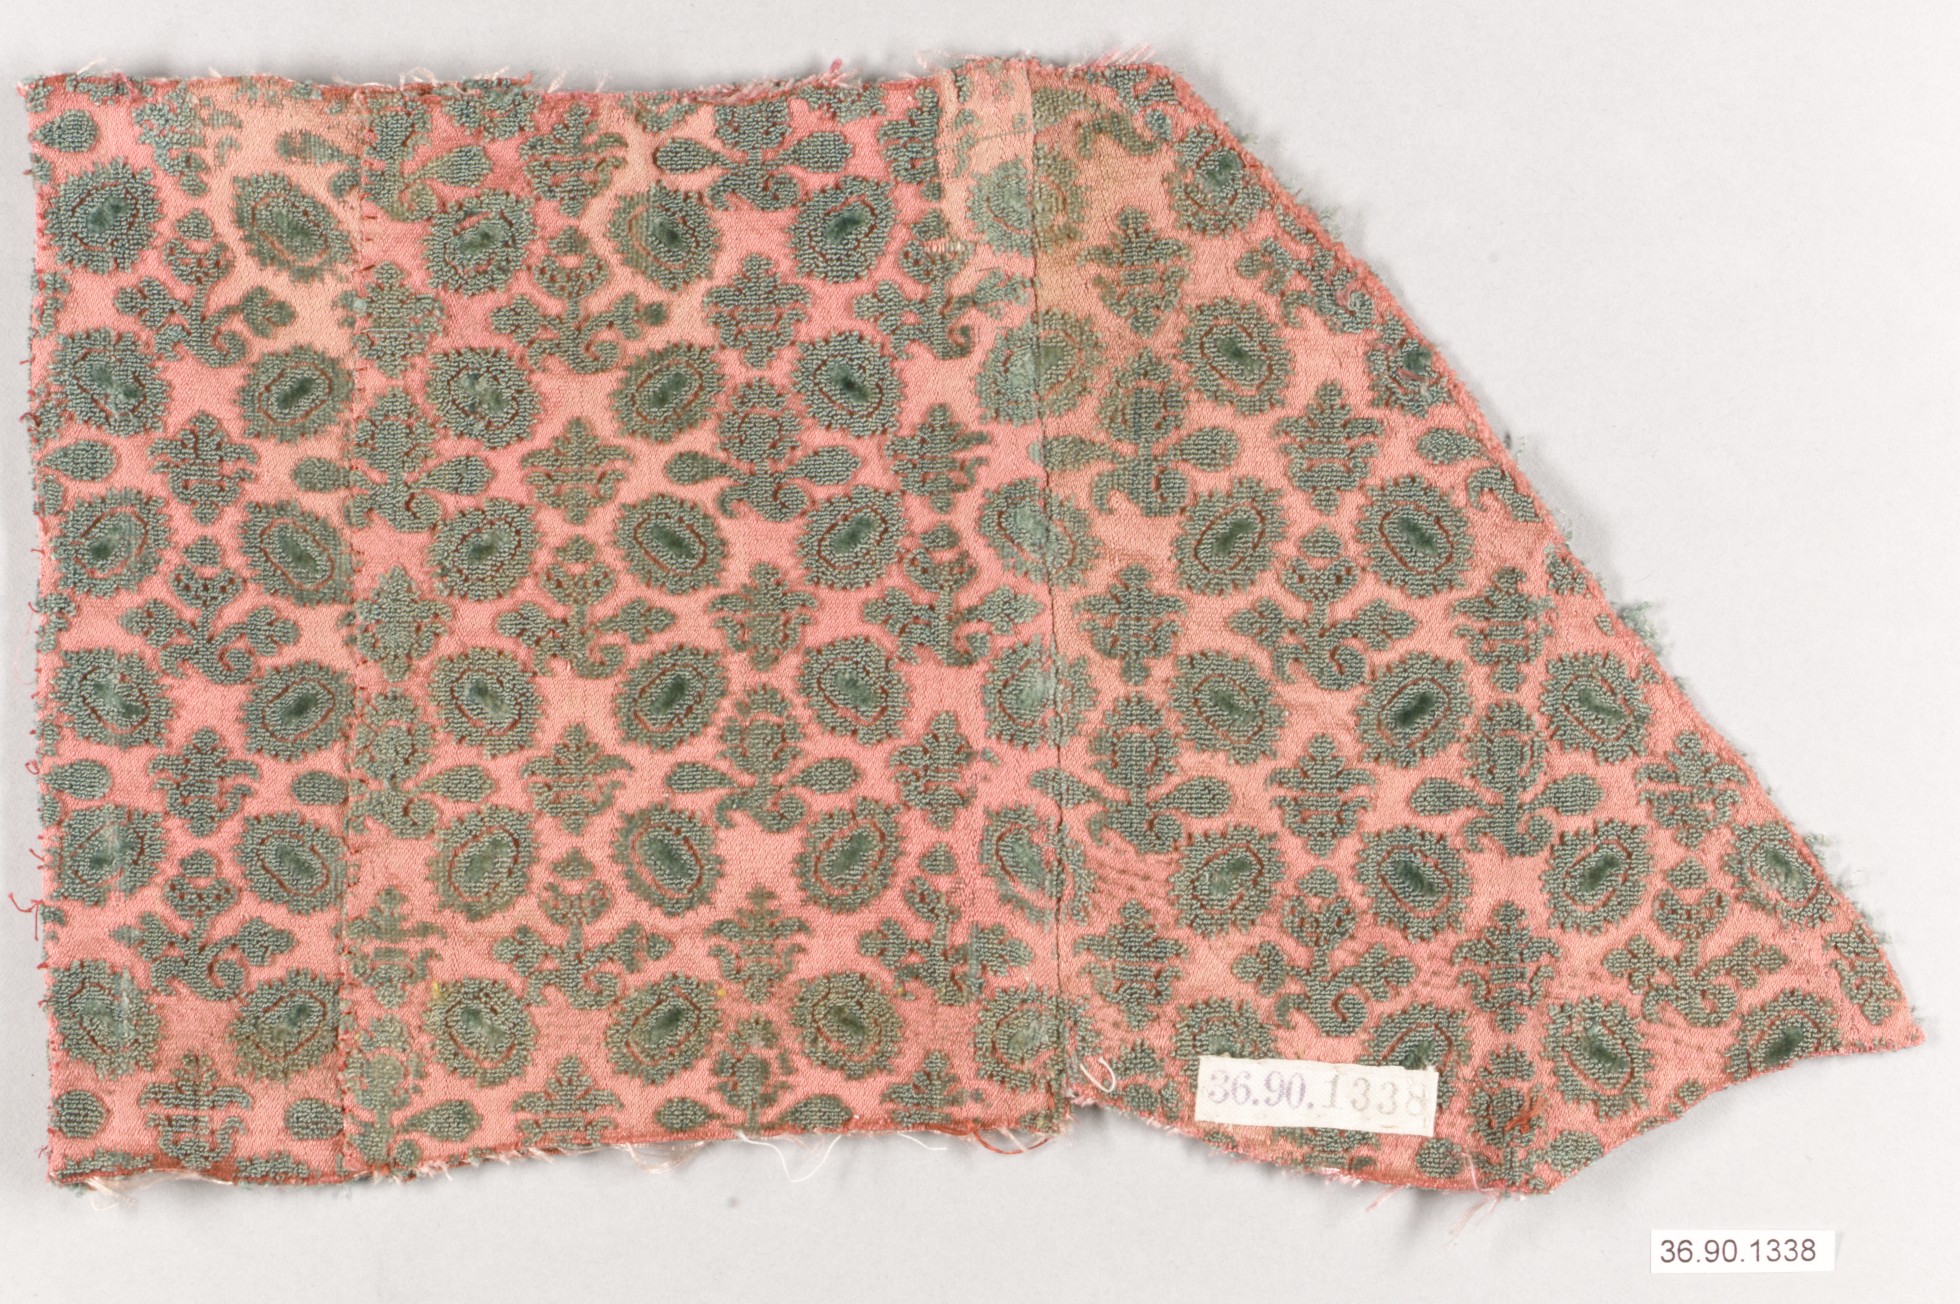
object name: piece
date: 1501-1700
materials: silk